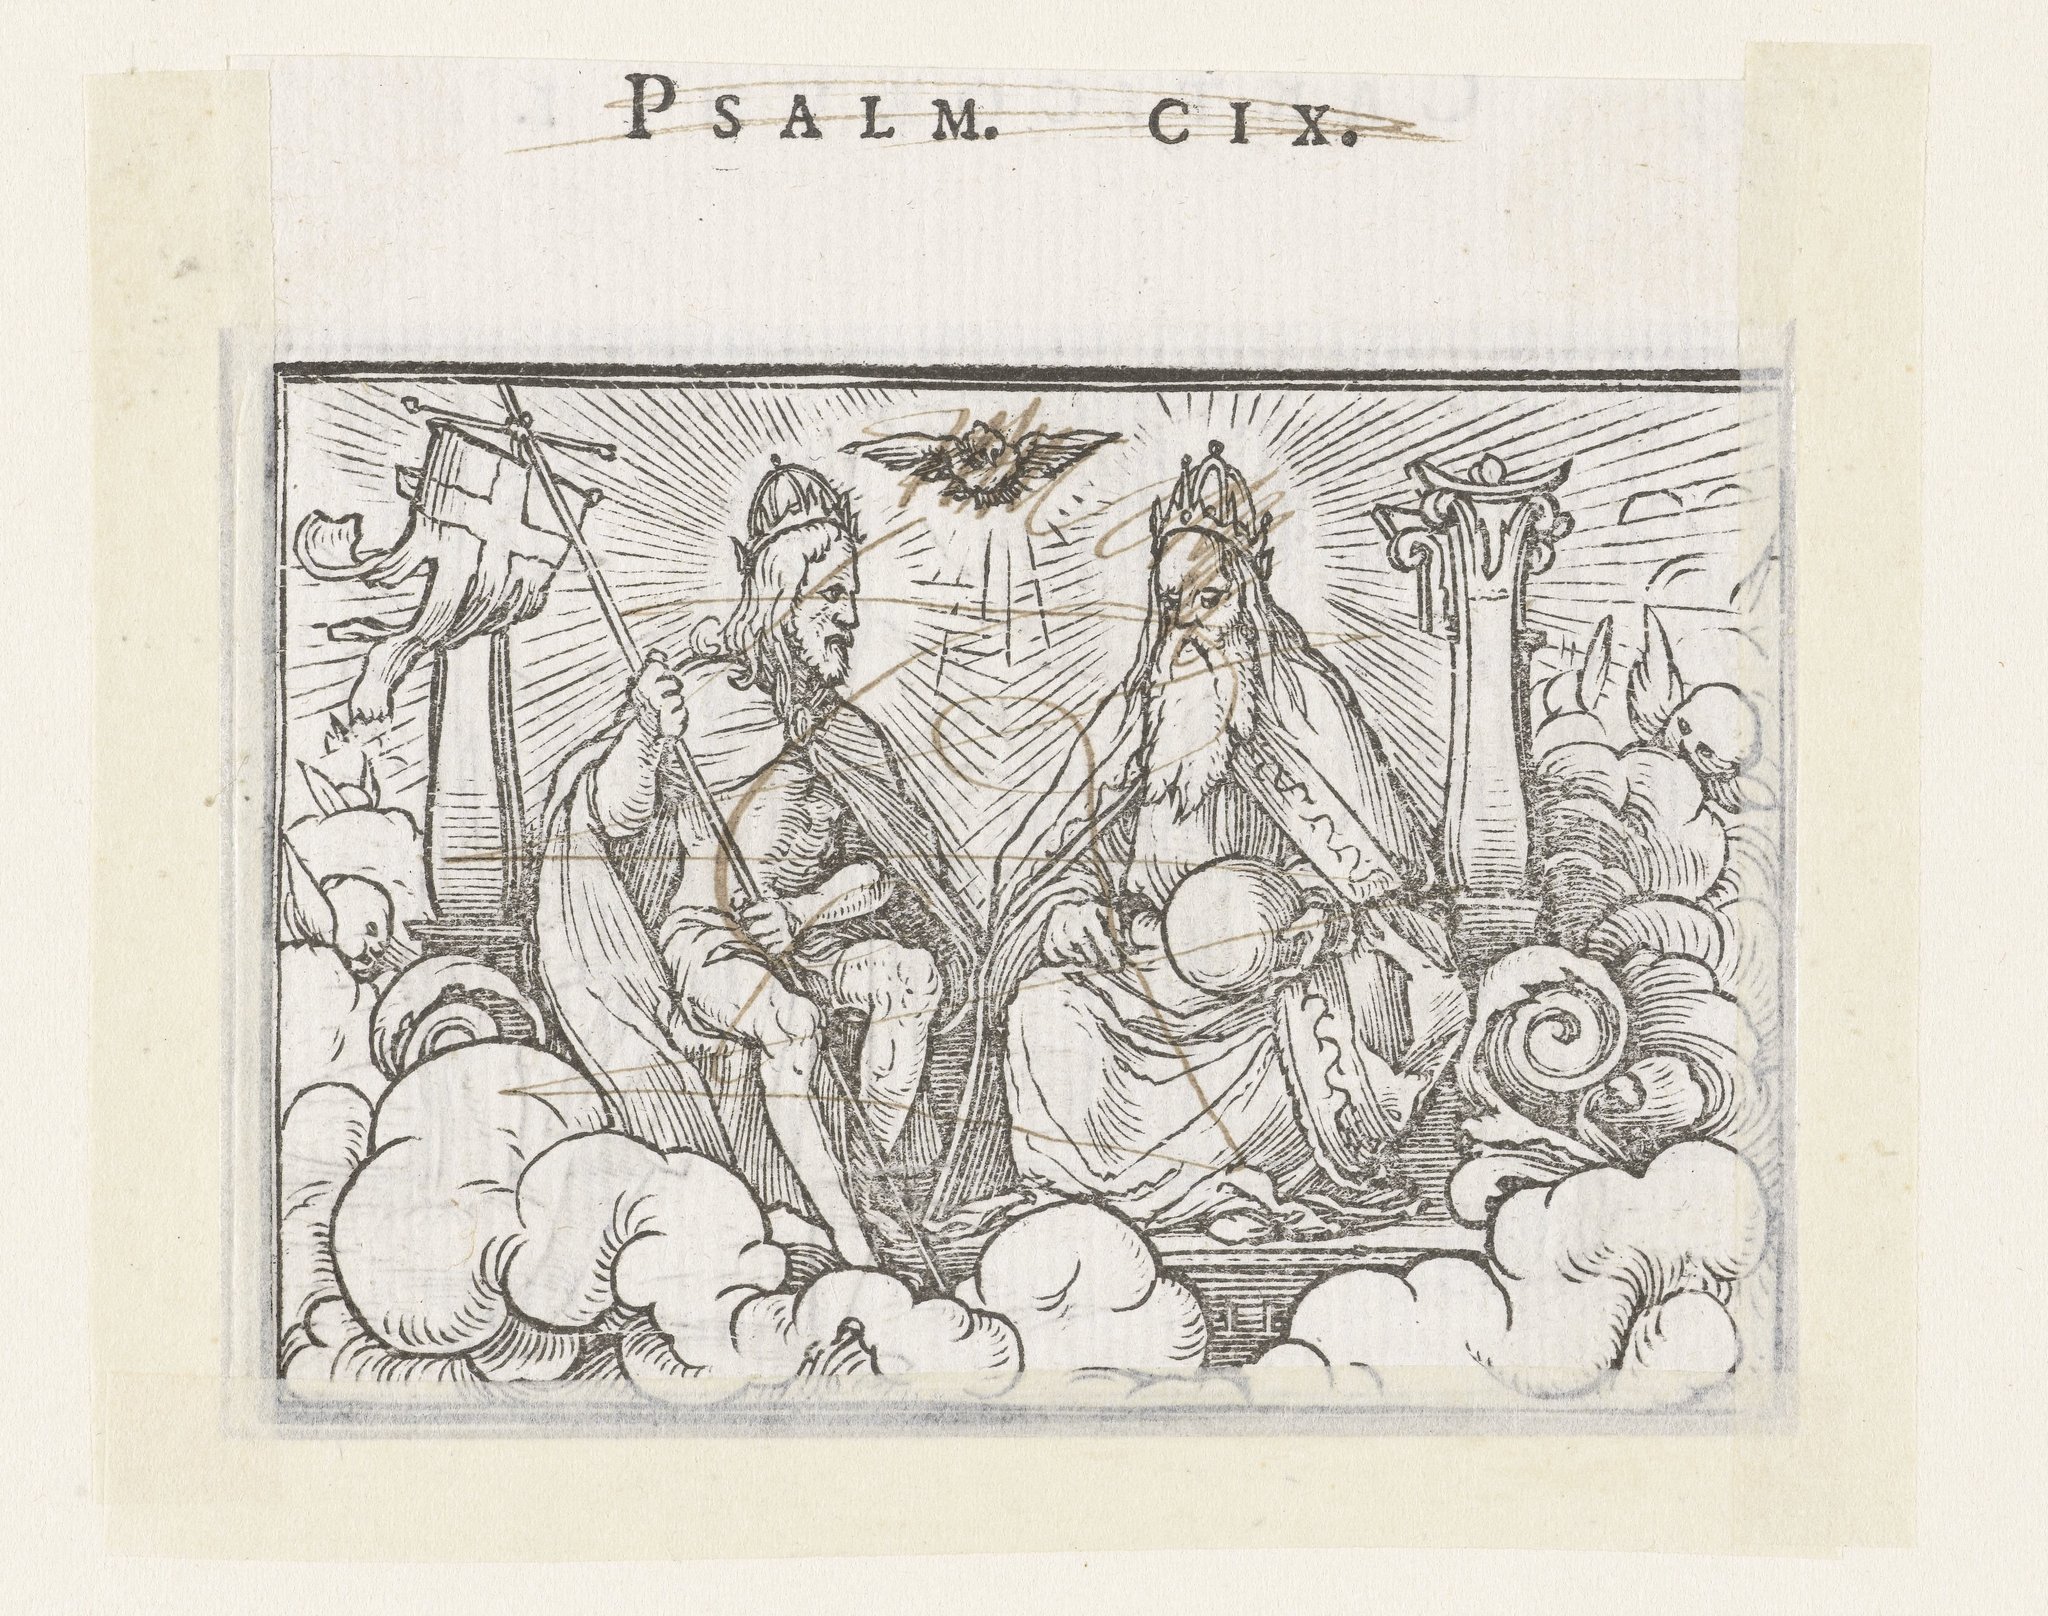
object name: print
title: Drieëenheid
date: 1538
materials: paper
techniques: woodcut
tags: the holy trinity, 'trinitas coelestis'; father, son and holy ghost ~ christian religion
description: Christus tronend met kruisvaandel naast God tussen zuilen in de hemel. Tussen hen in zweeft het symbool van de heilige Geest, een duif. In de marge boven de afbeelding staat de tekst Psalm CIX. De prent is beklad met pen in bruin.